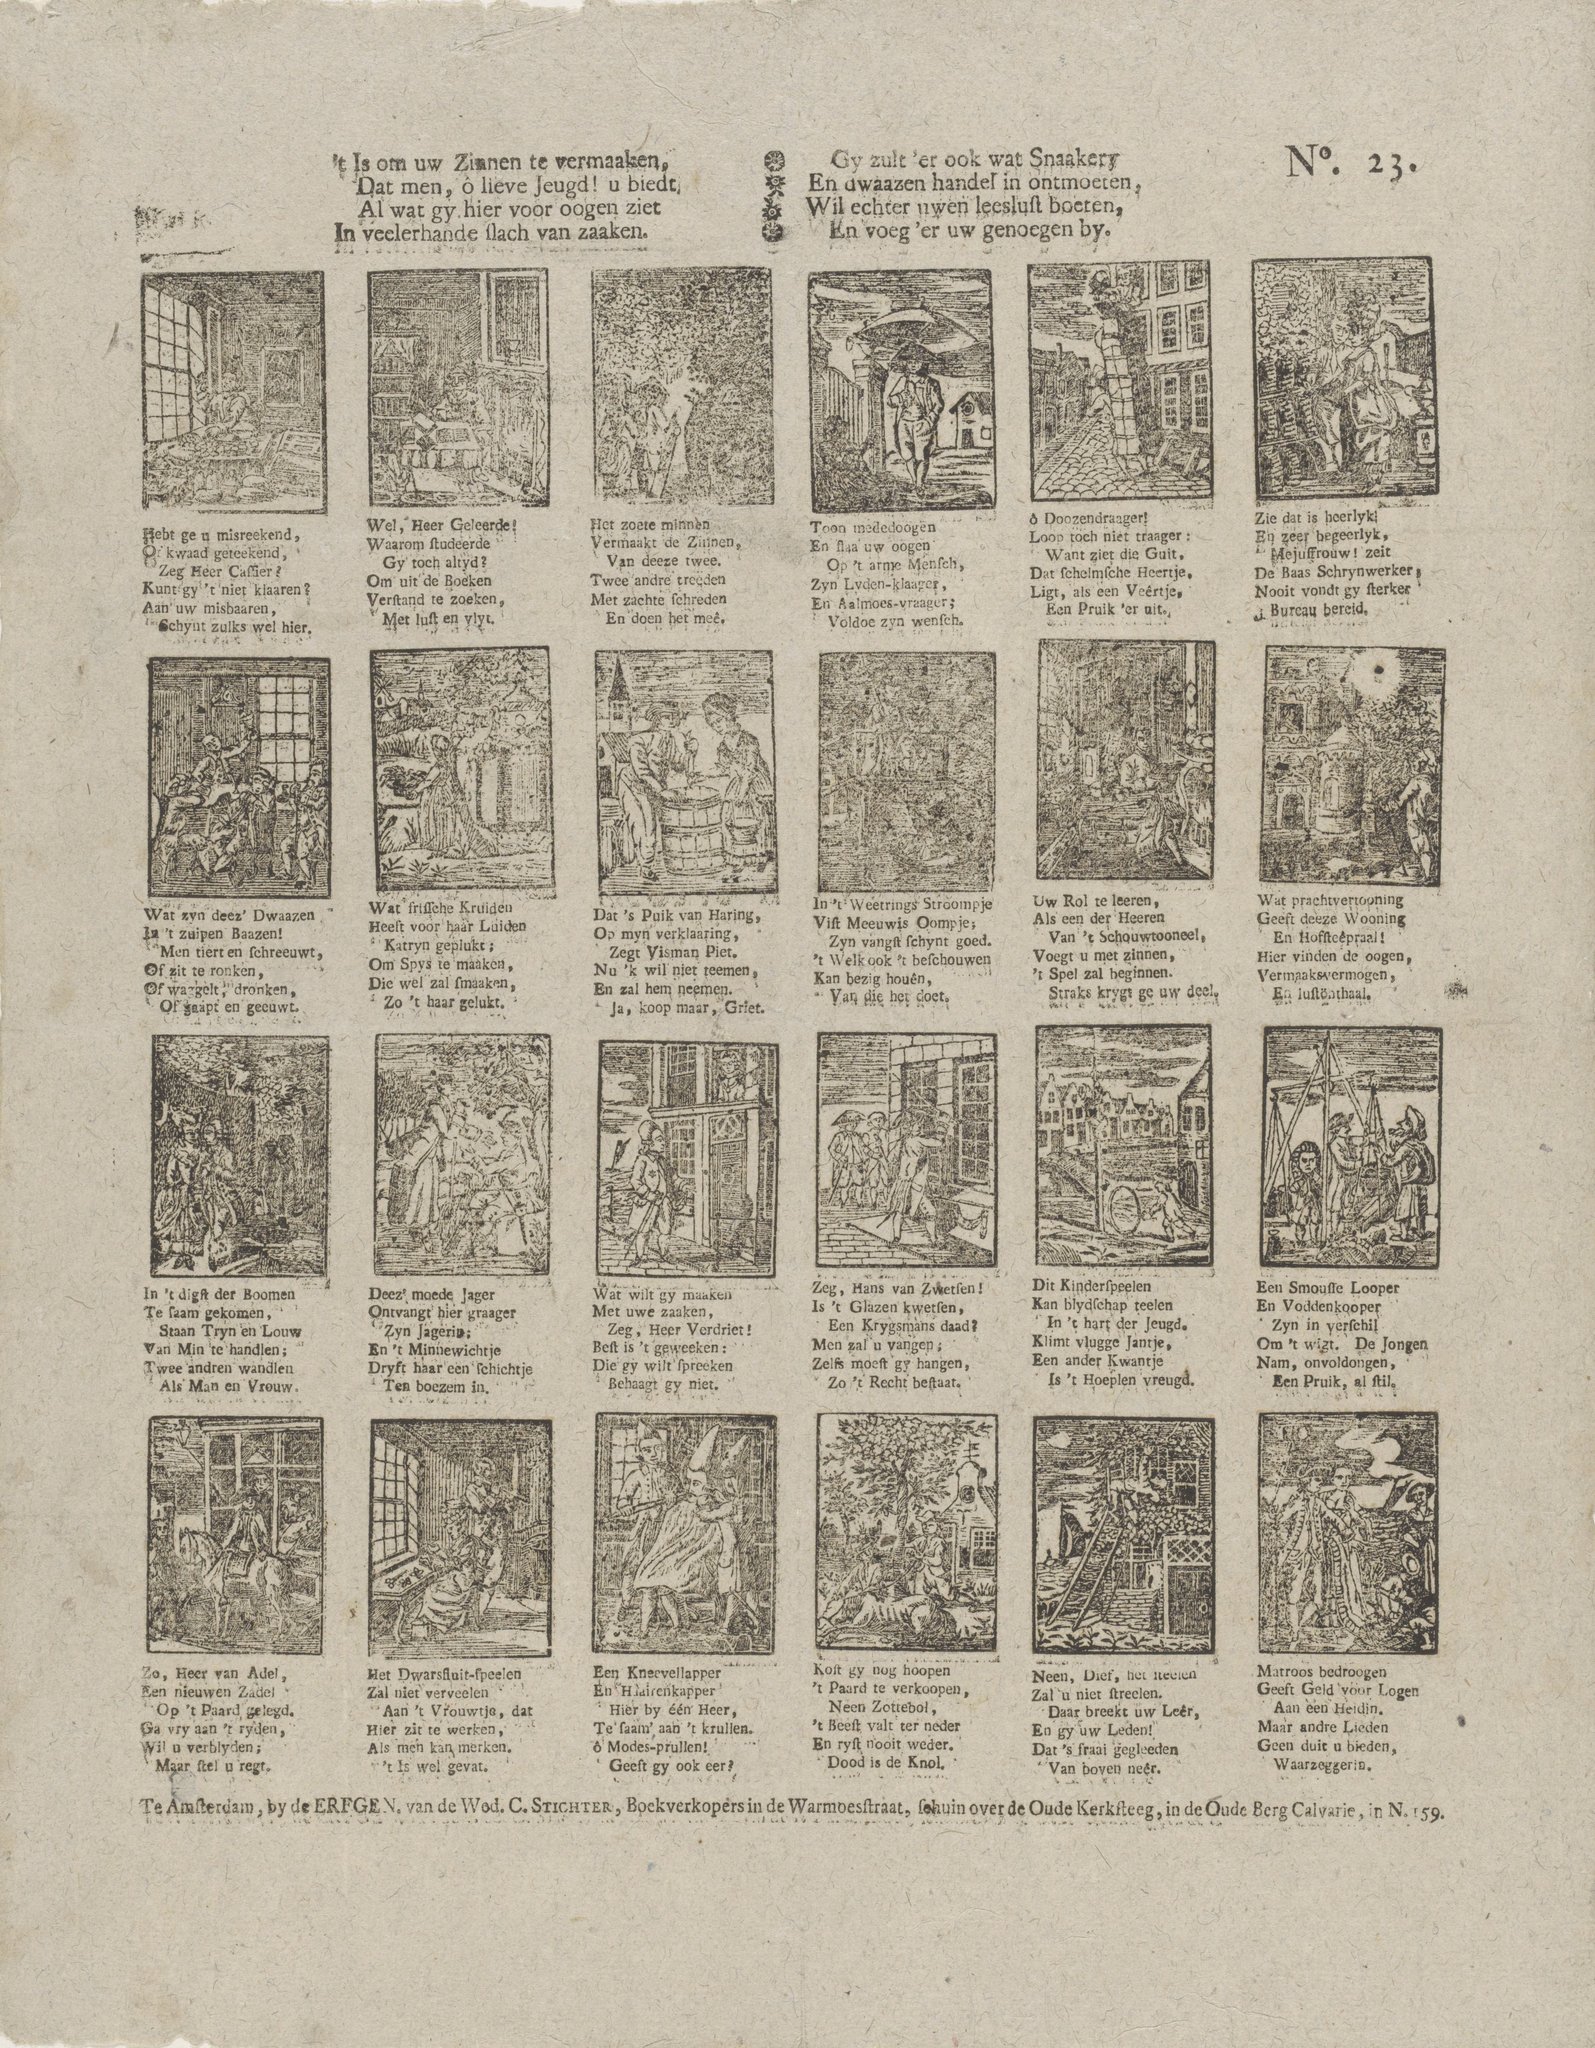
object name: popular print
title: 'T is om uw zinnen te vermaaken, / Dan men, ô lieve jeugd! u biedt [(...)]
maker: Anonymous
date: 1715-1813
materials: paper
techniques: letterpress printing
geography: netherlands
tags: craft-production, skilled handiwork, human types, working class, labourers, characters (human types), crafts and industries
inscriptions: collector's mark: Lugt 2760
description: Blad met 24 voorstellingen van verschillende figuren en beroepen. Onder elke afbeelding een zesregelig vers. Genummerd rechtsboven: No. 23.